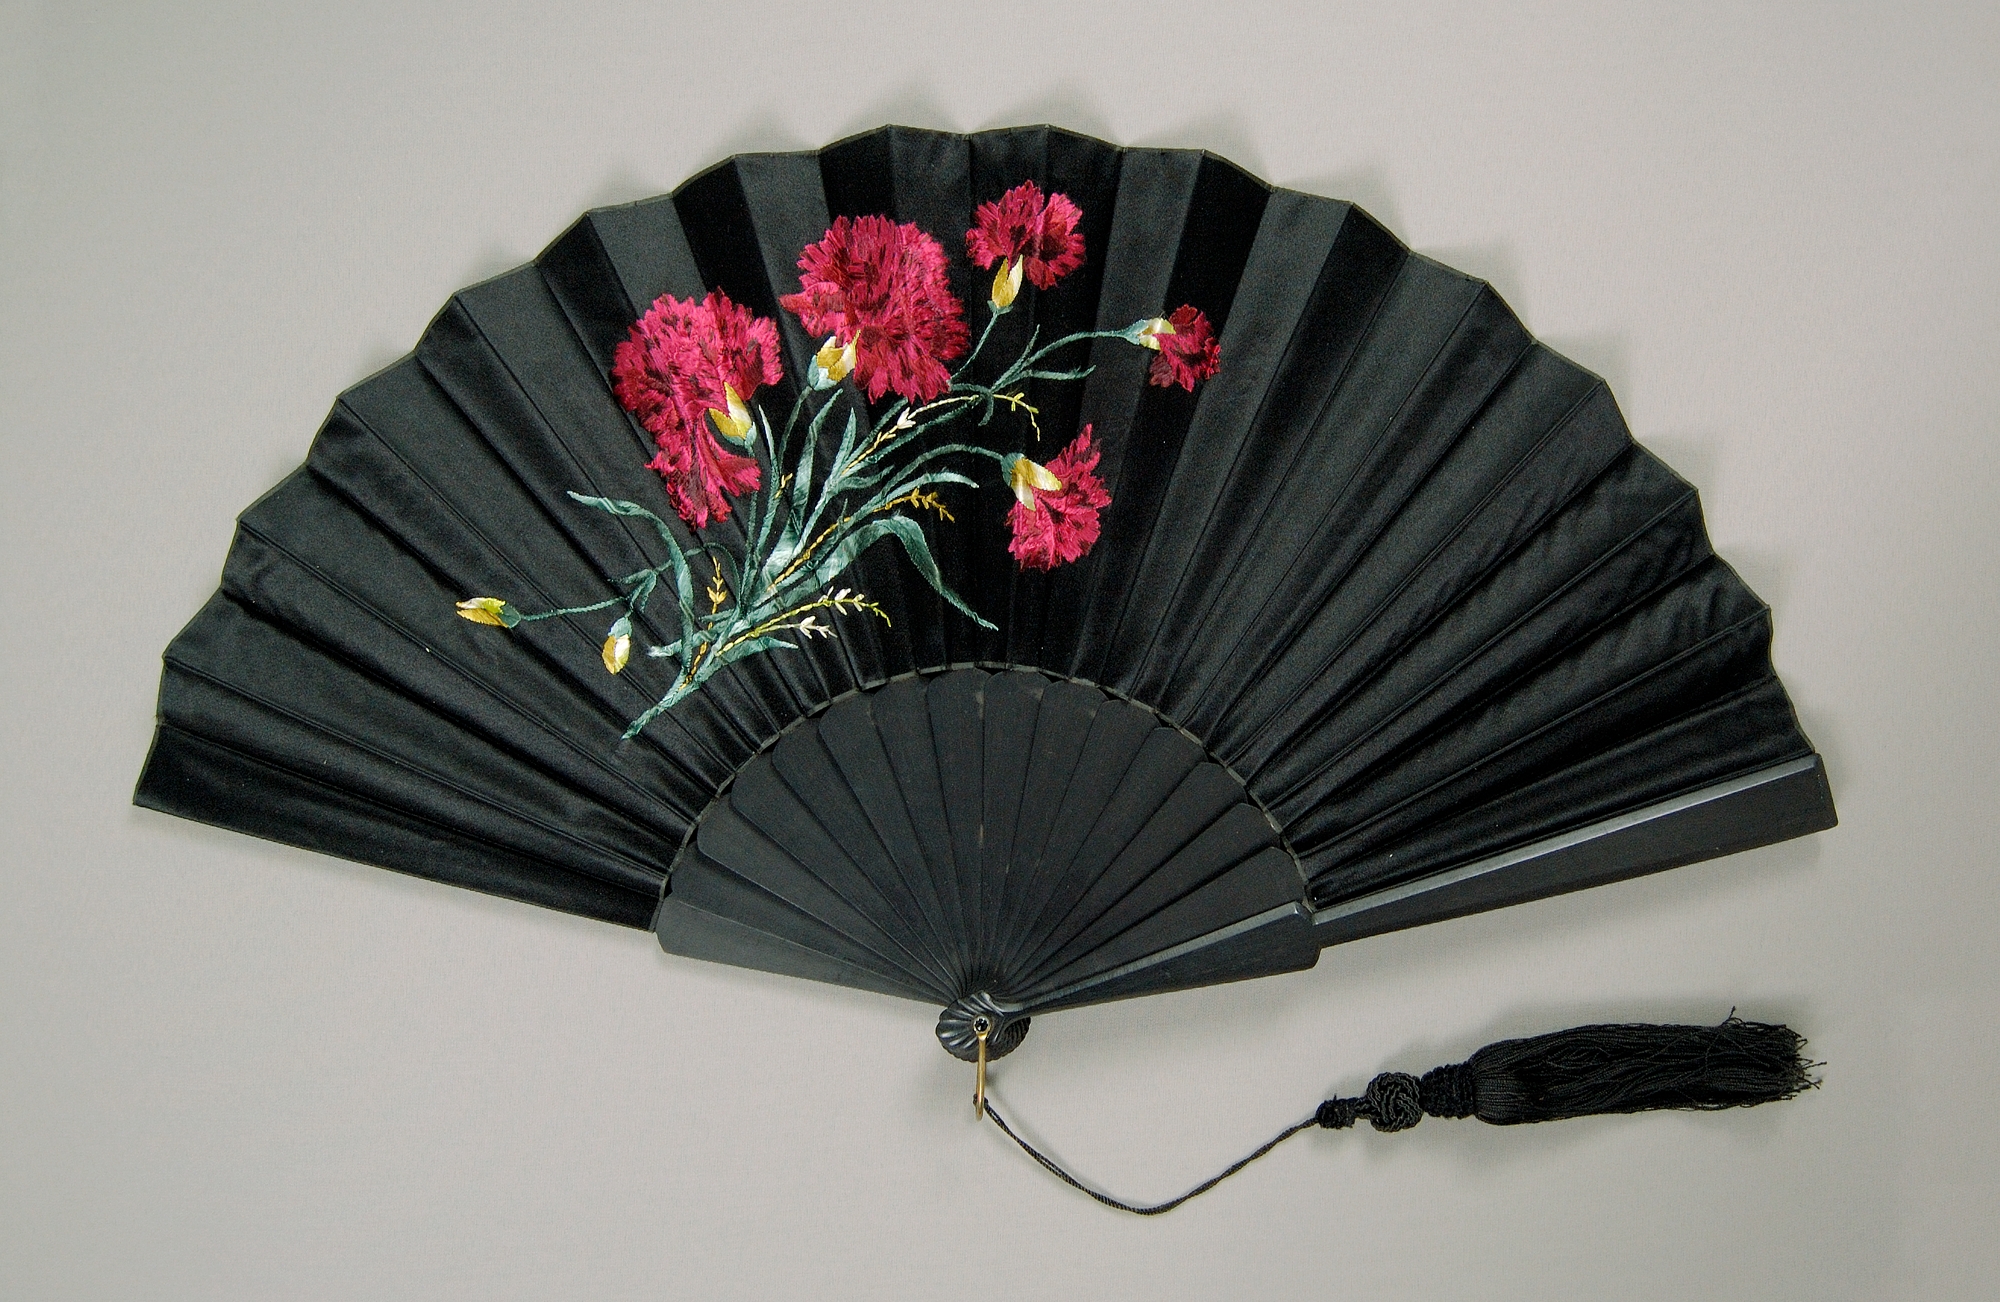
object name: fan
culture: american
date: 1885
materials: metal, silk, wood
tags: flowers